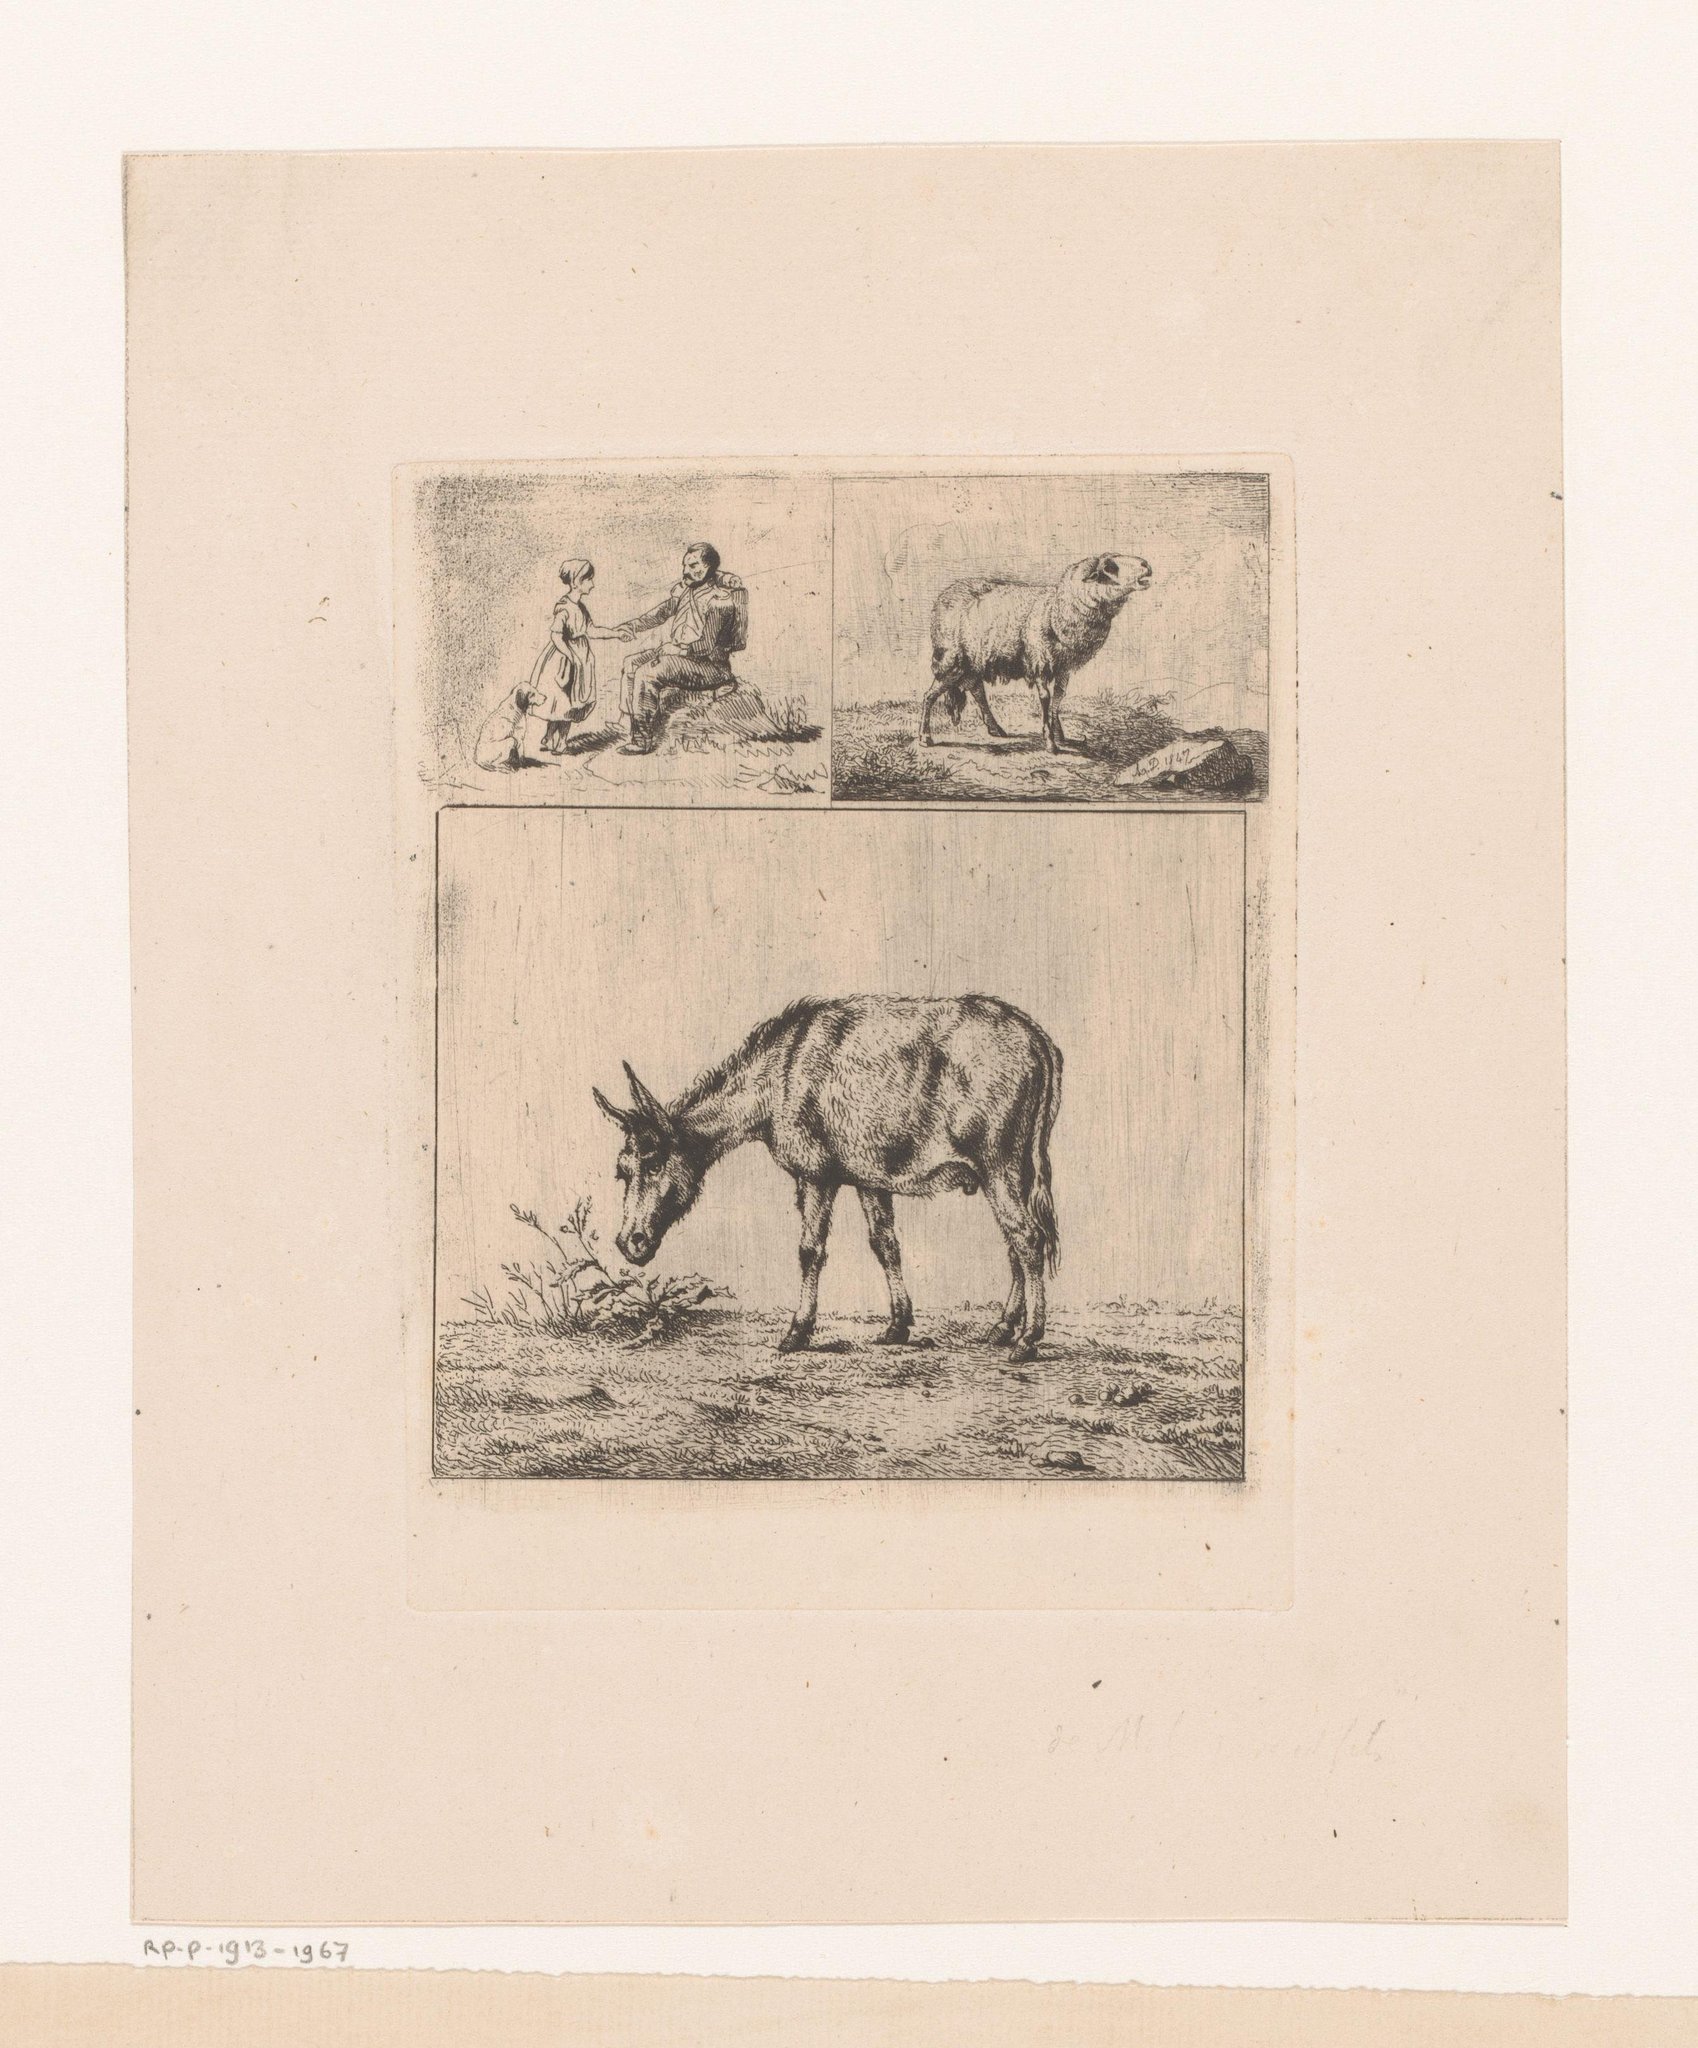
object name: print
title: Studieblad met een zittende soldaat en meisje, een schaap en een ezel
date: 1847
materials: paper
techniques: etching, intaglio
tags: ass, donkey, sheep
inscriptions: collector's mark: Lugt 2228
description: De voostellingen van het schaap en de ezel zijn gemaakt naar werken van Verboeckhoven. Deze twee voorstellingen zouden zijn gemaakt door Jean Martin De Mol.